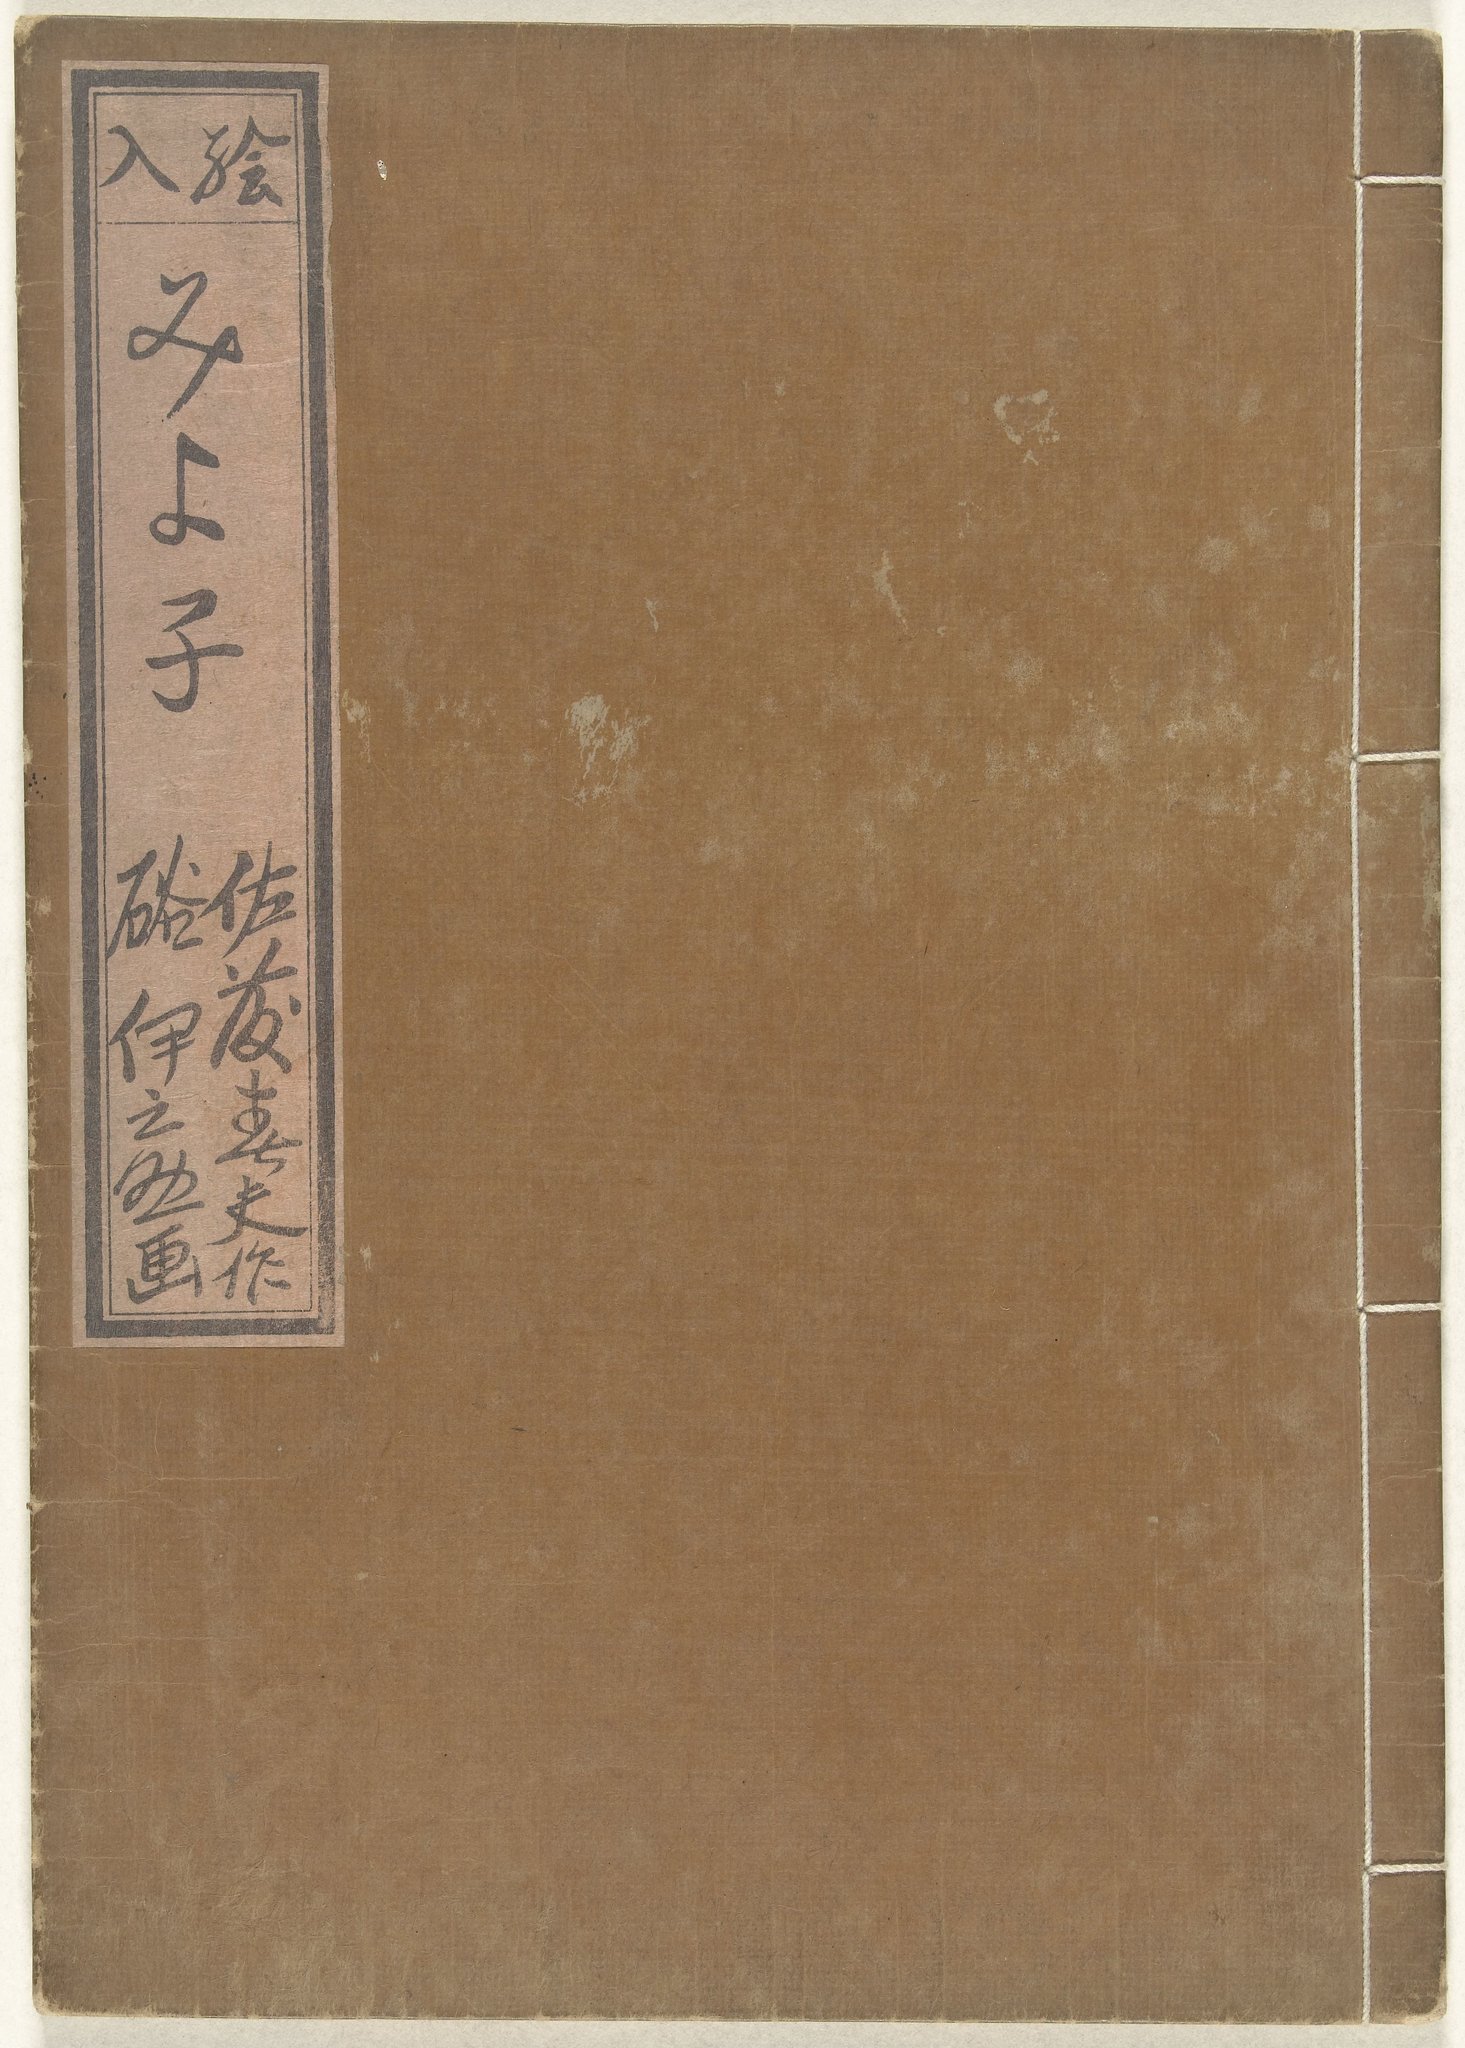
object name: book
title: Miyoko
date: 1933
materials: paper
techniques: woodcut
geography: japan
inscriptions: date